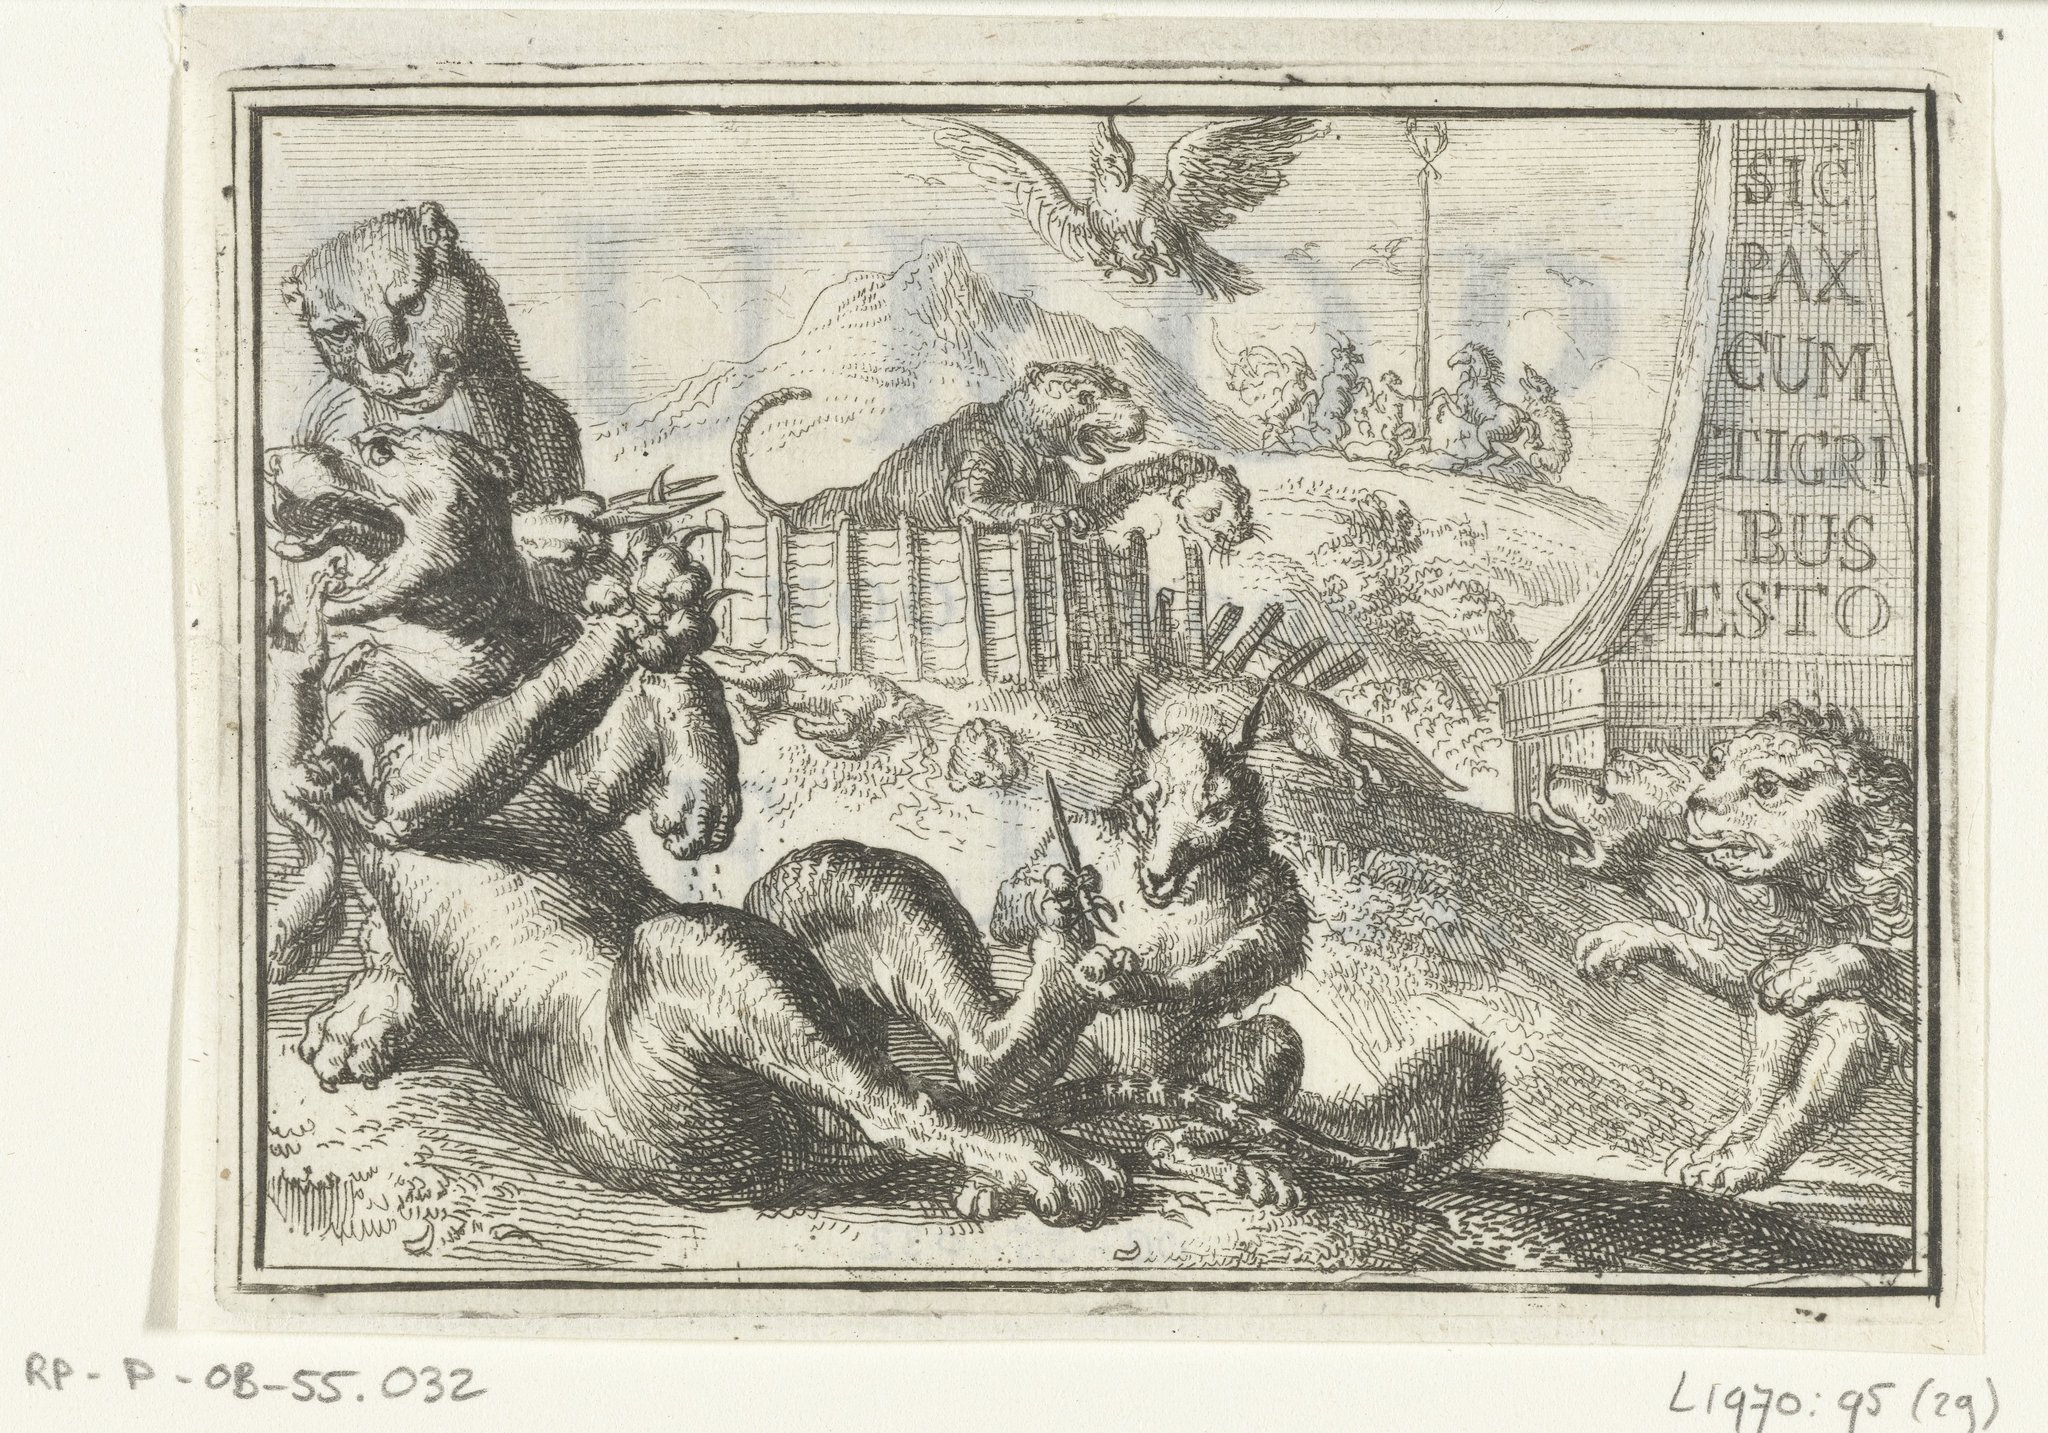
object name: print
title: Titelblad voor het pamflet: Europe nooit voor een, 1702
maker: romeyn de hooghe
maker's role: draughtsman, goldsmith, painter, print maker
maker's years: 1645-1708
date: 1702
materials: paper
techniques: engraving, etching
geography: netherlands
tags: the hague, william iii (prince of orange and king of england, scotland, and ireland), lodewijk xiv (koning van frankrijk), vienna, leopold i (keizer van duitsland)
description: Een leeuw (Willem III) en een vos knippen de nagels en breken de tanden van de tijger (Frankrijk), de adelaar (Keizerrijk) ziet goedkeurend toe. De macht van Frankrijk in Europa door Willem III en het keizerrijk beknot. Op de achtergrond een obelisk met opschrift in het Latijn. Titel staat op apart tekstblad.